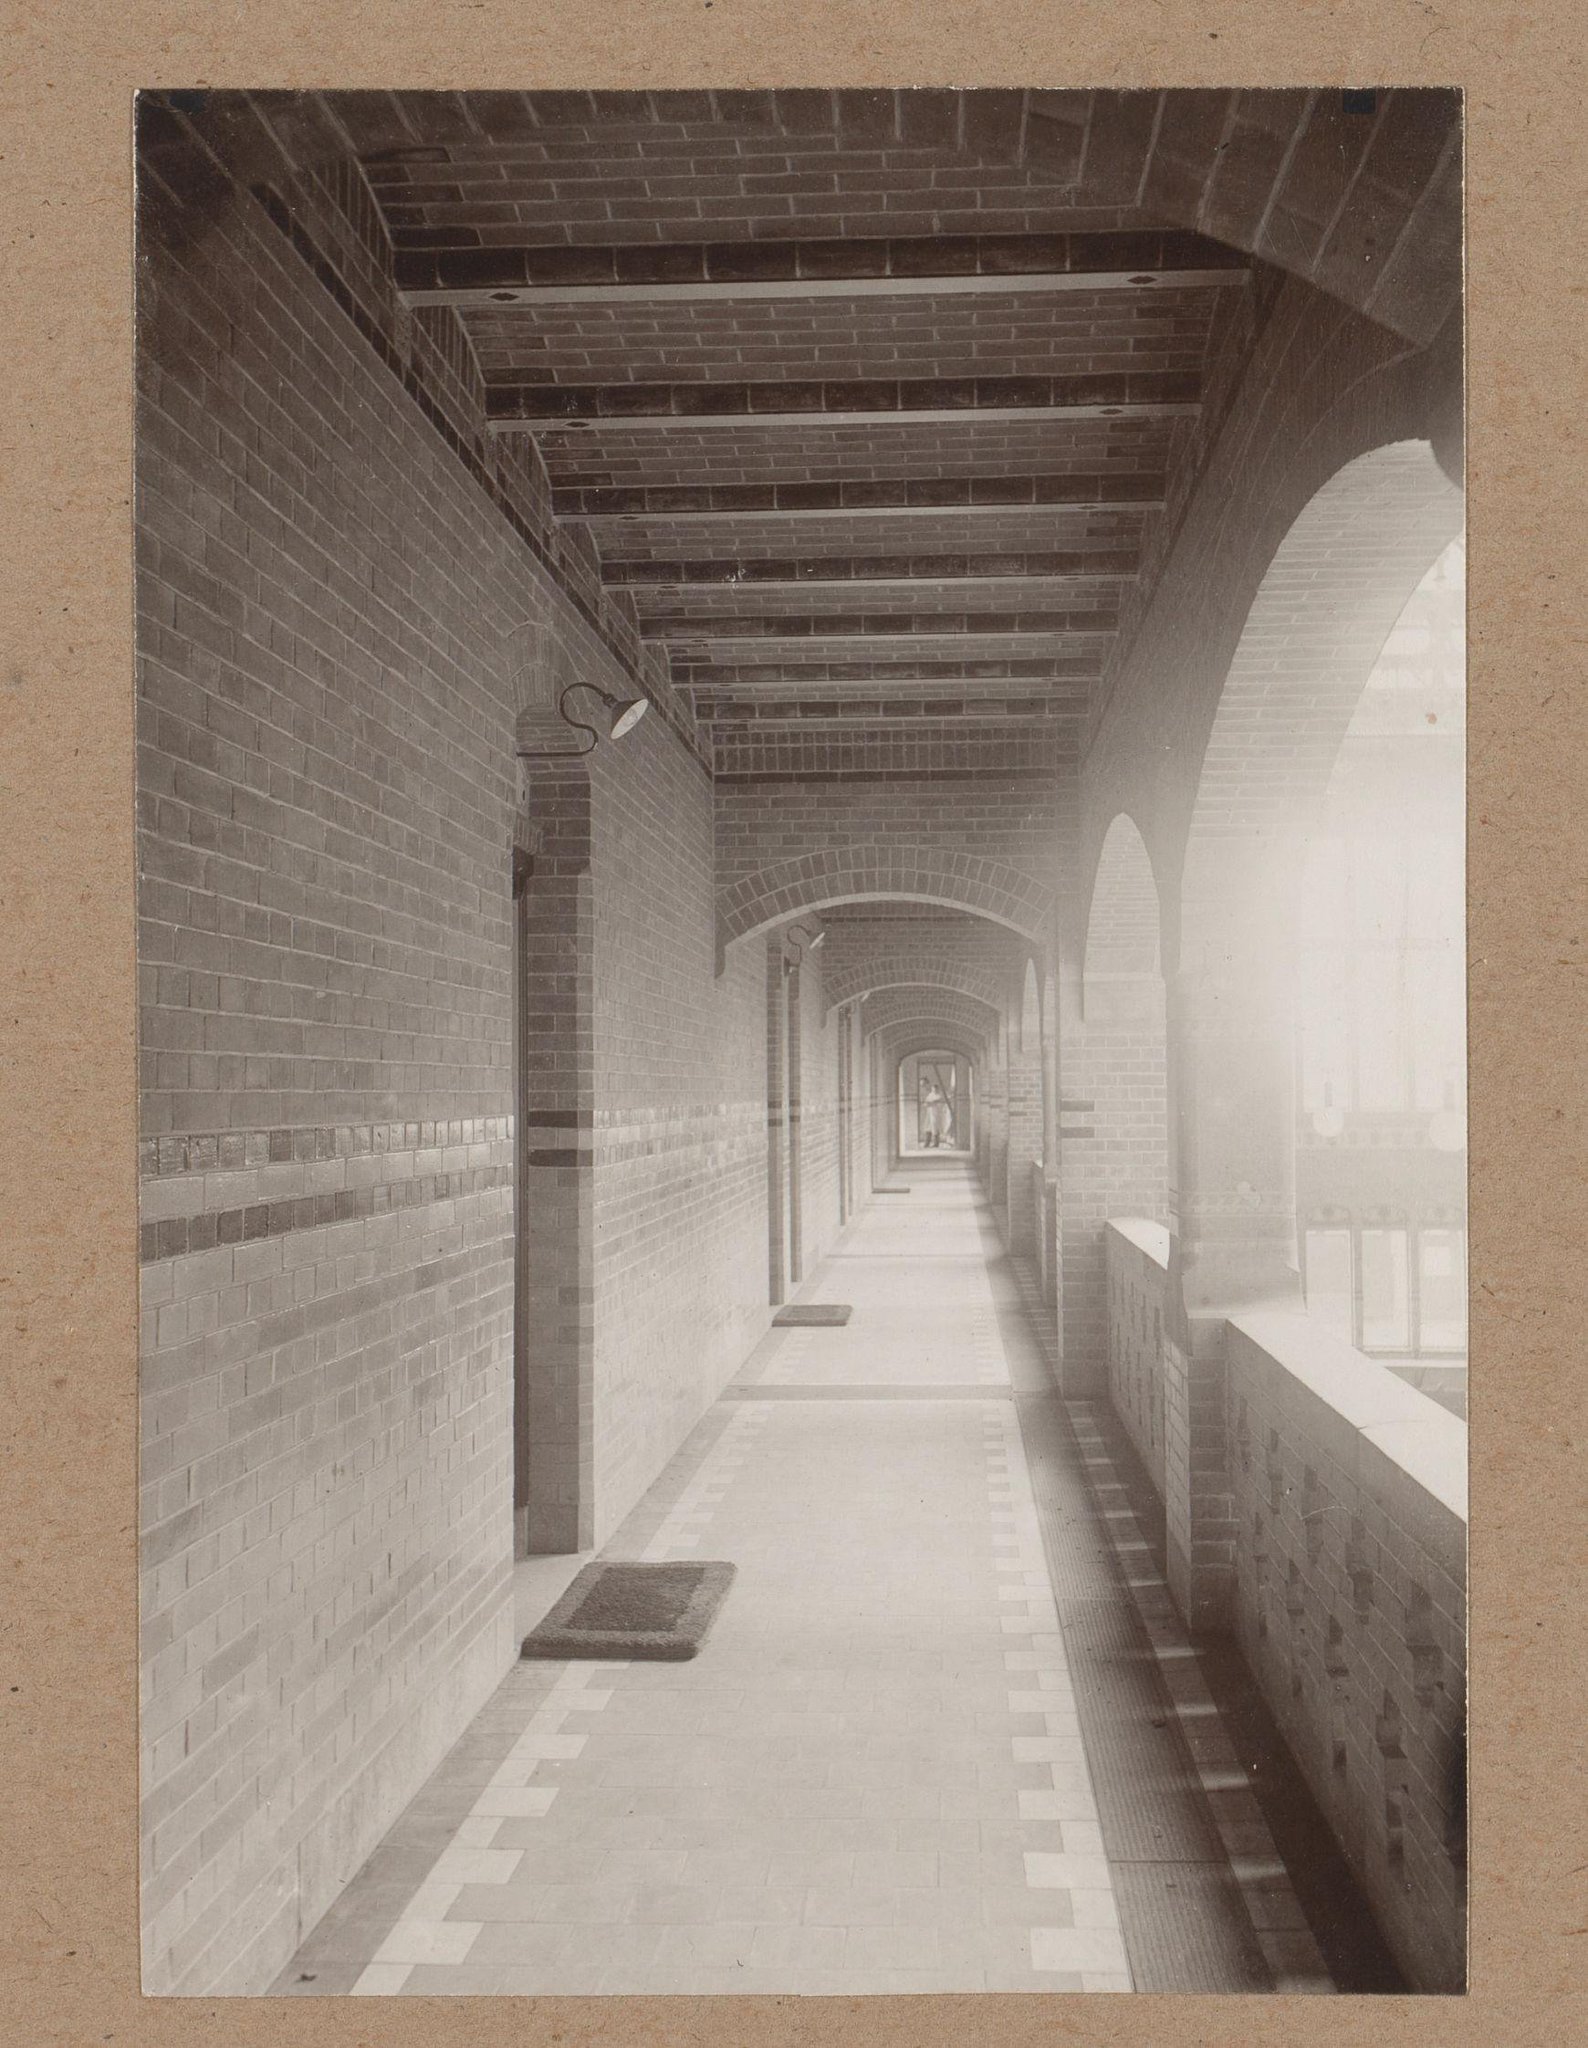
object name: photograph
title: Galerij van de Graanbeurs in de Beurs van Berlage te Amsterdam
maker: Anonymous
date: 1903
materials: paper, cardboard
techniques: gelatin silver print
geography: amsterdam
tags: stock exchange, stock-market, gallery (spacious corridor)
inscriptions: stamp: ‘Rijksmuseum/ Amsterdam’